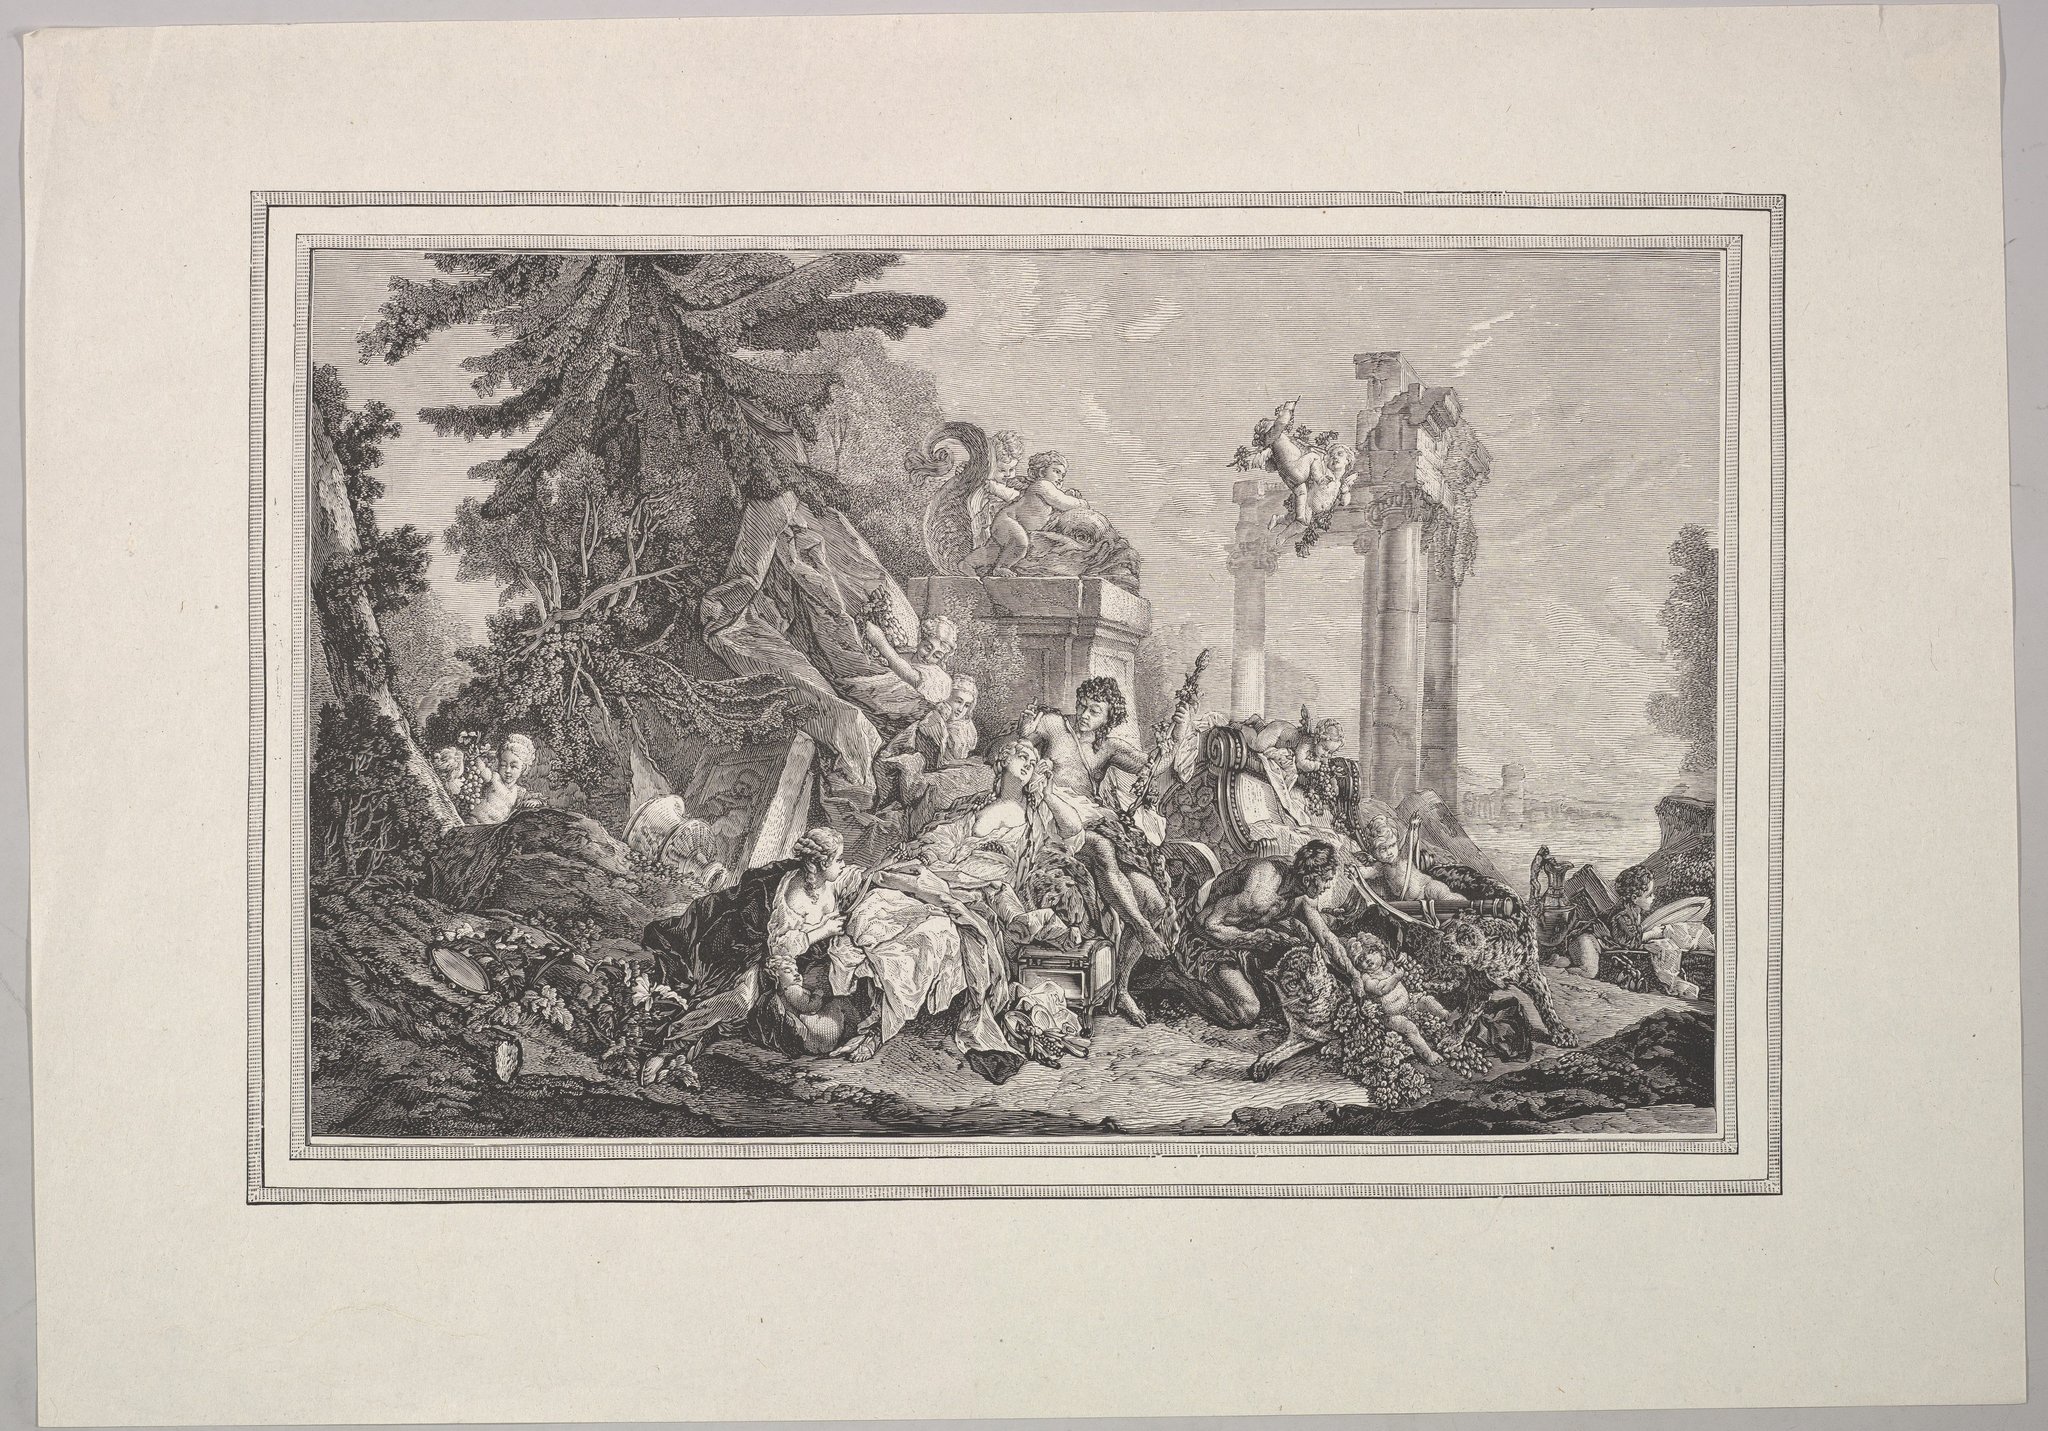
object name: print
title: Wood Engraving of a Tapestry of Bacchus and Ariadne, from "Amours des Dieux" (Loves of the Gods)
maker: Anonymous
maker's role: artist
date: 1749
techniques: engraving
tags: ariadne,putti,bacchus